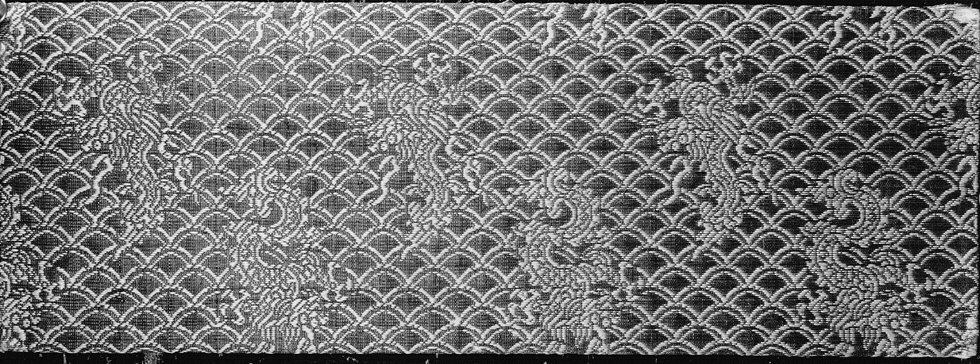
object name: sutra cover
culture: chinese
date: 1501-1600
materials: silk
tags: dragons